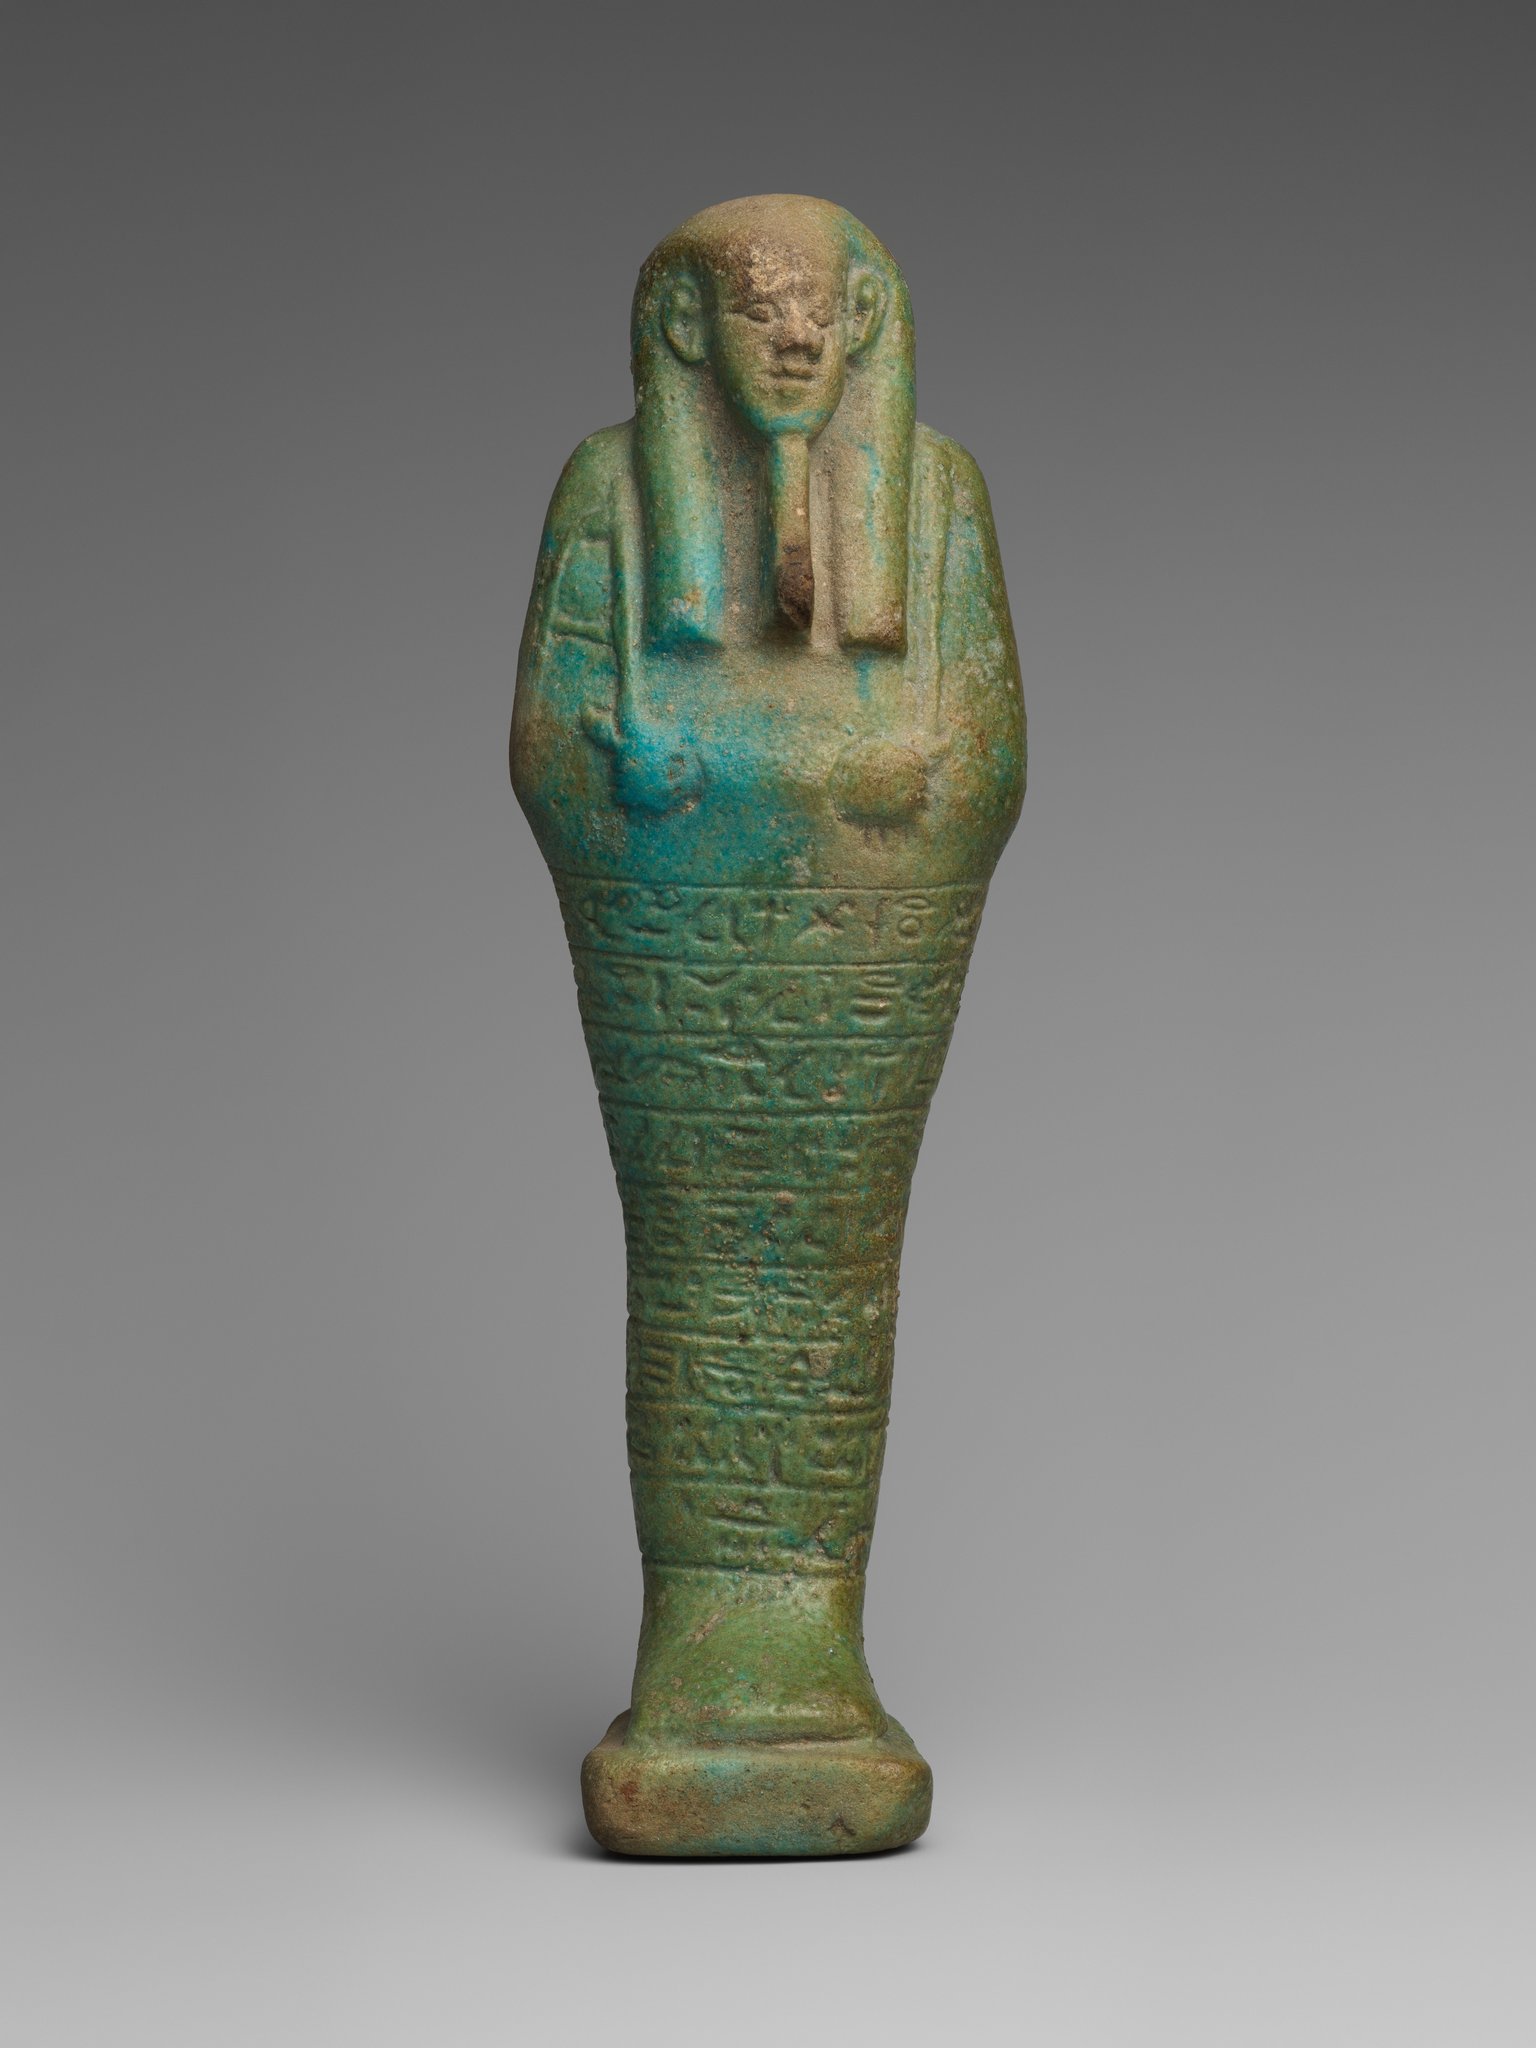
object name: shabti, pa abu meh, psamtik seneb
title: Shabti of the Treasurer of Lower Egypt Pa-abumeh, called Psamtik-seneb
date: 595-380 BCE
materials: faience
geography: egypt